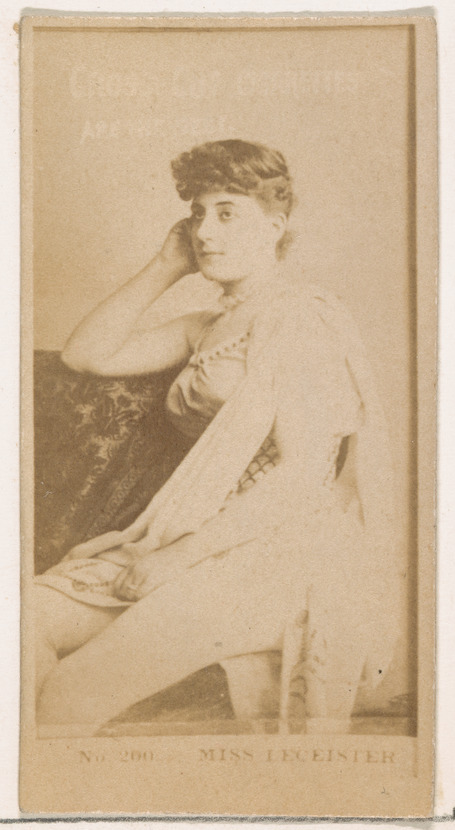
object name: print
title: Card Number 200, Miss Leicester, from the Actors and Actresses series (N145-2) issued by Duke Sons & Co. to promote Cross Cut Cigarettes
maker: w. duke, sons & co.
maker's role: publisher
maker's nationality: american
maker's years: 1870-1920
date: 1880-1889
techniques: albumen silver print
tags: portraits,women,actresses